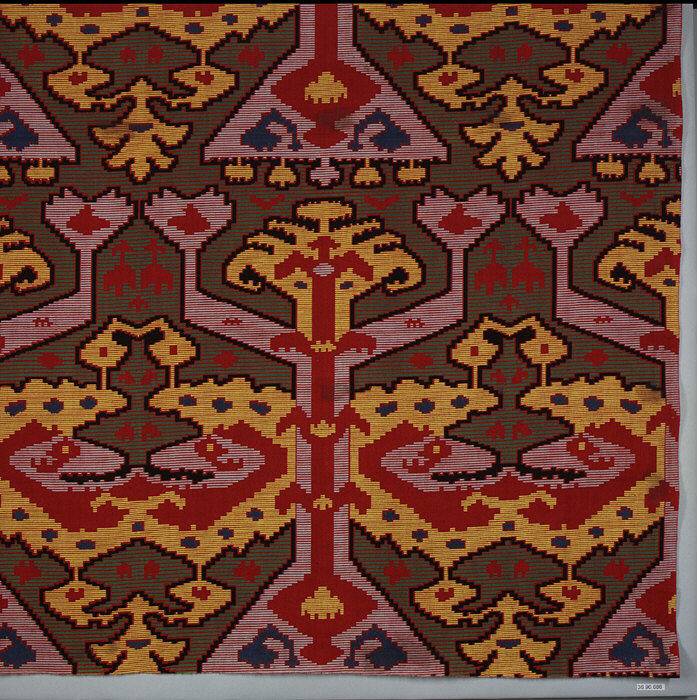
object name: piece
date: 1867-1900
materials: cotton